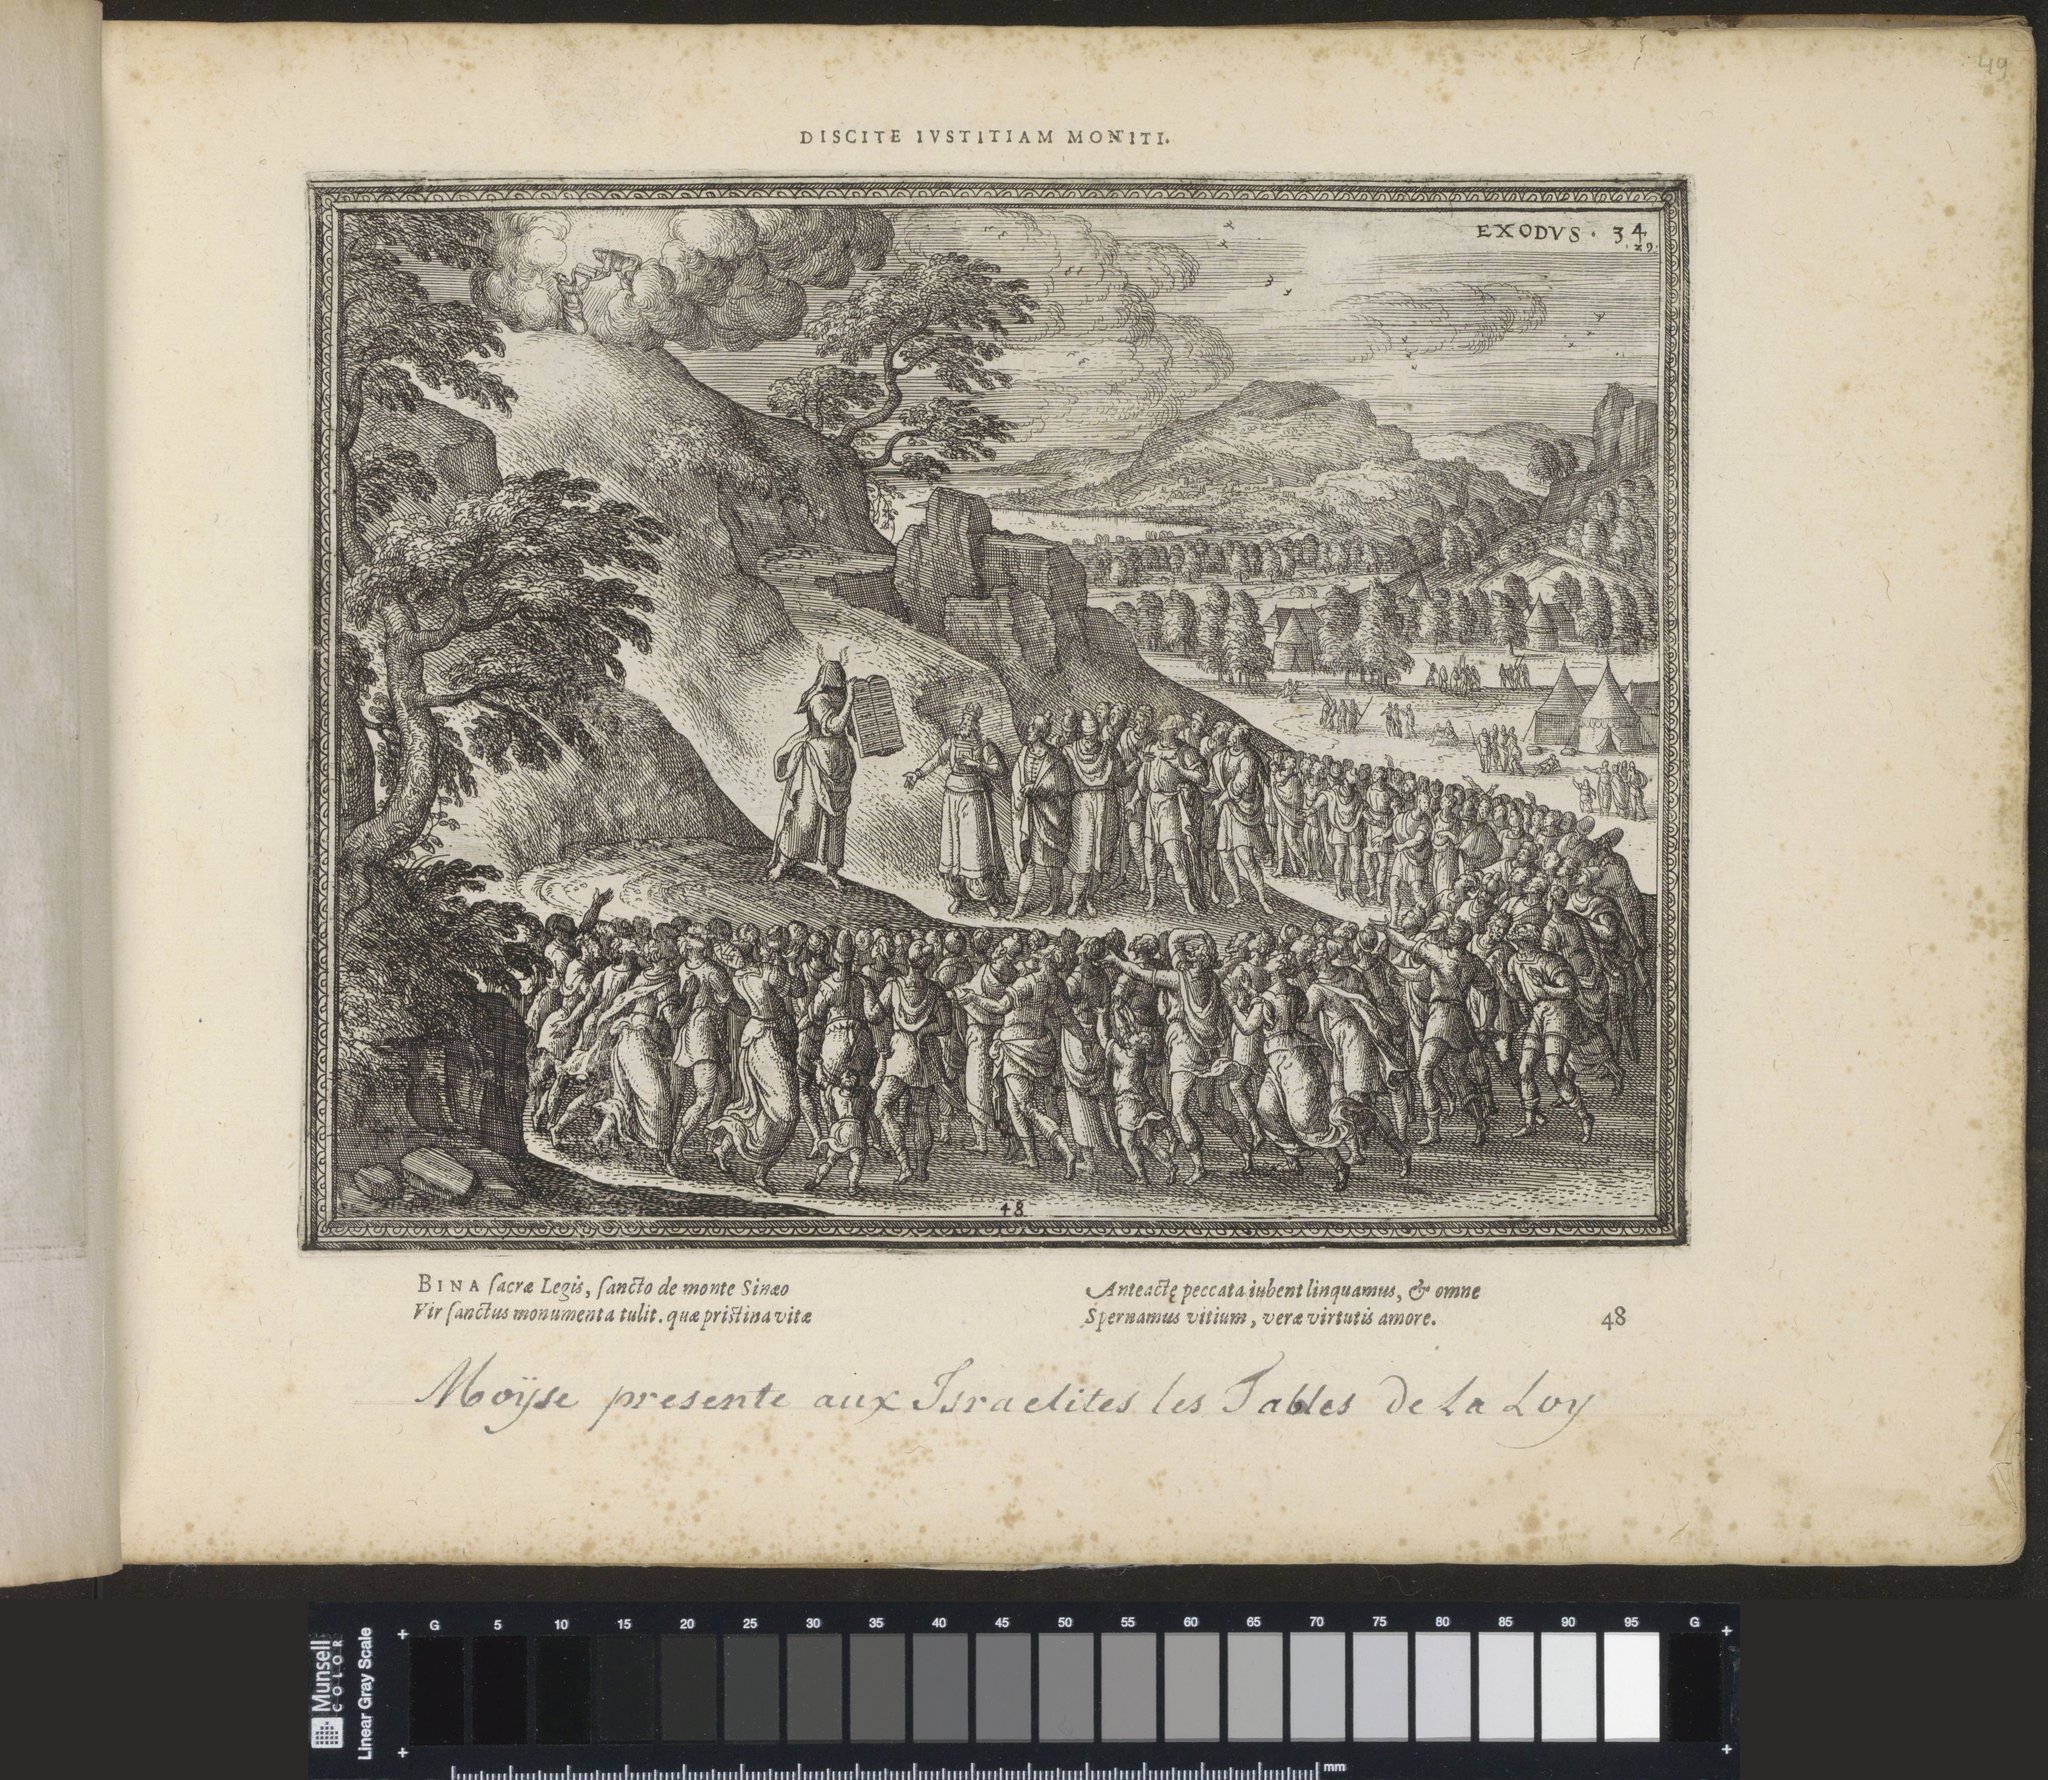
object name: album leaf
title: Imagines et figurae bibliorum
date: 1582-1593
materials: paper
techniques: etching, letterpress printing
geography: amsterdam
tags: the new tables of the law (exodus 34), moses covers his face with a veil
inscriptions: inscription: ‘Moijse presente aux Israelites les tables de la Loy’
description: Linksboven op de berg Sinaï ontvangt Mozes de tafelen der wet. Onderaan de berg toont Mozes de tafelen aan het volk. Zijn gezicht is bedekt met een doek (Ex. 34:29). Met een motto in het Latijn boven de voorstelling en een vierregelig onderschrift in het Latijn onder de prent. De prent maakt deel uit van een album.